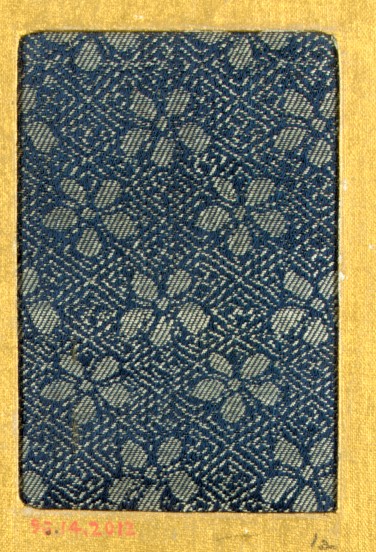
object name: piece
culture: japanese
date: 1701-1900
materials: silk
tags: flowers